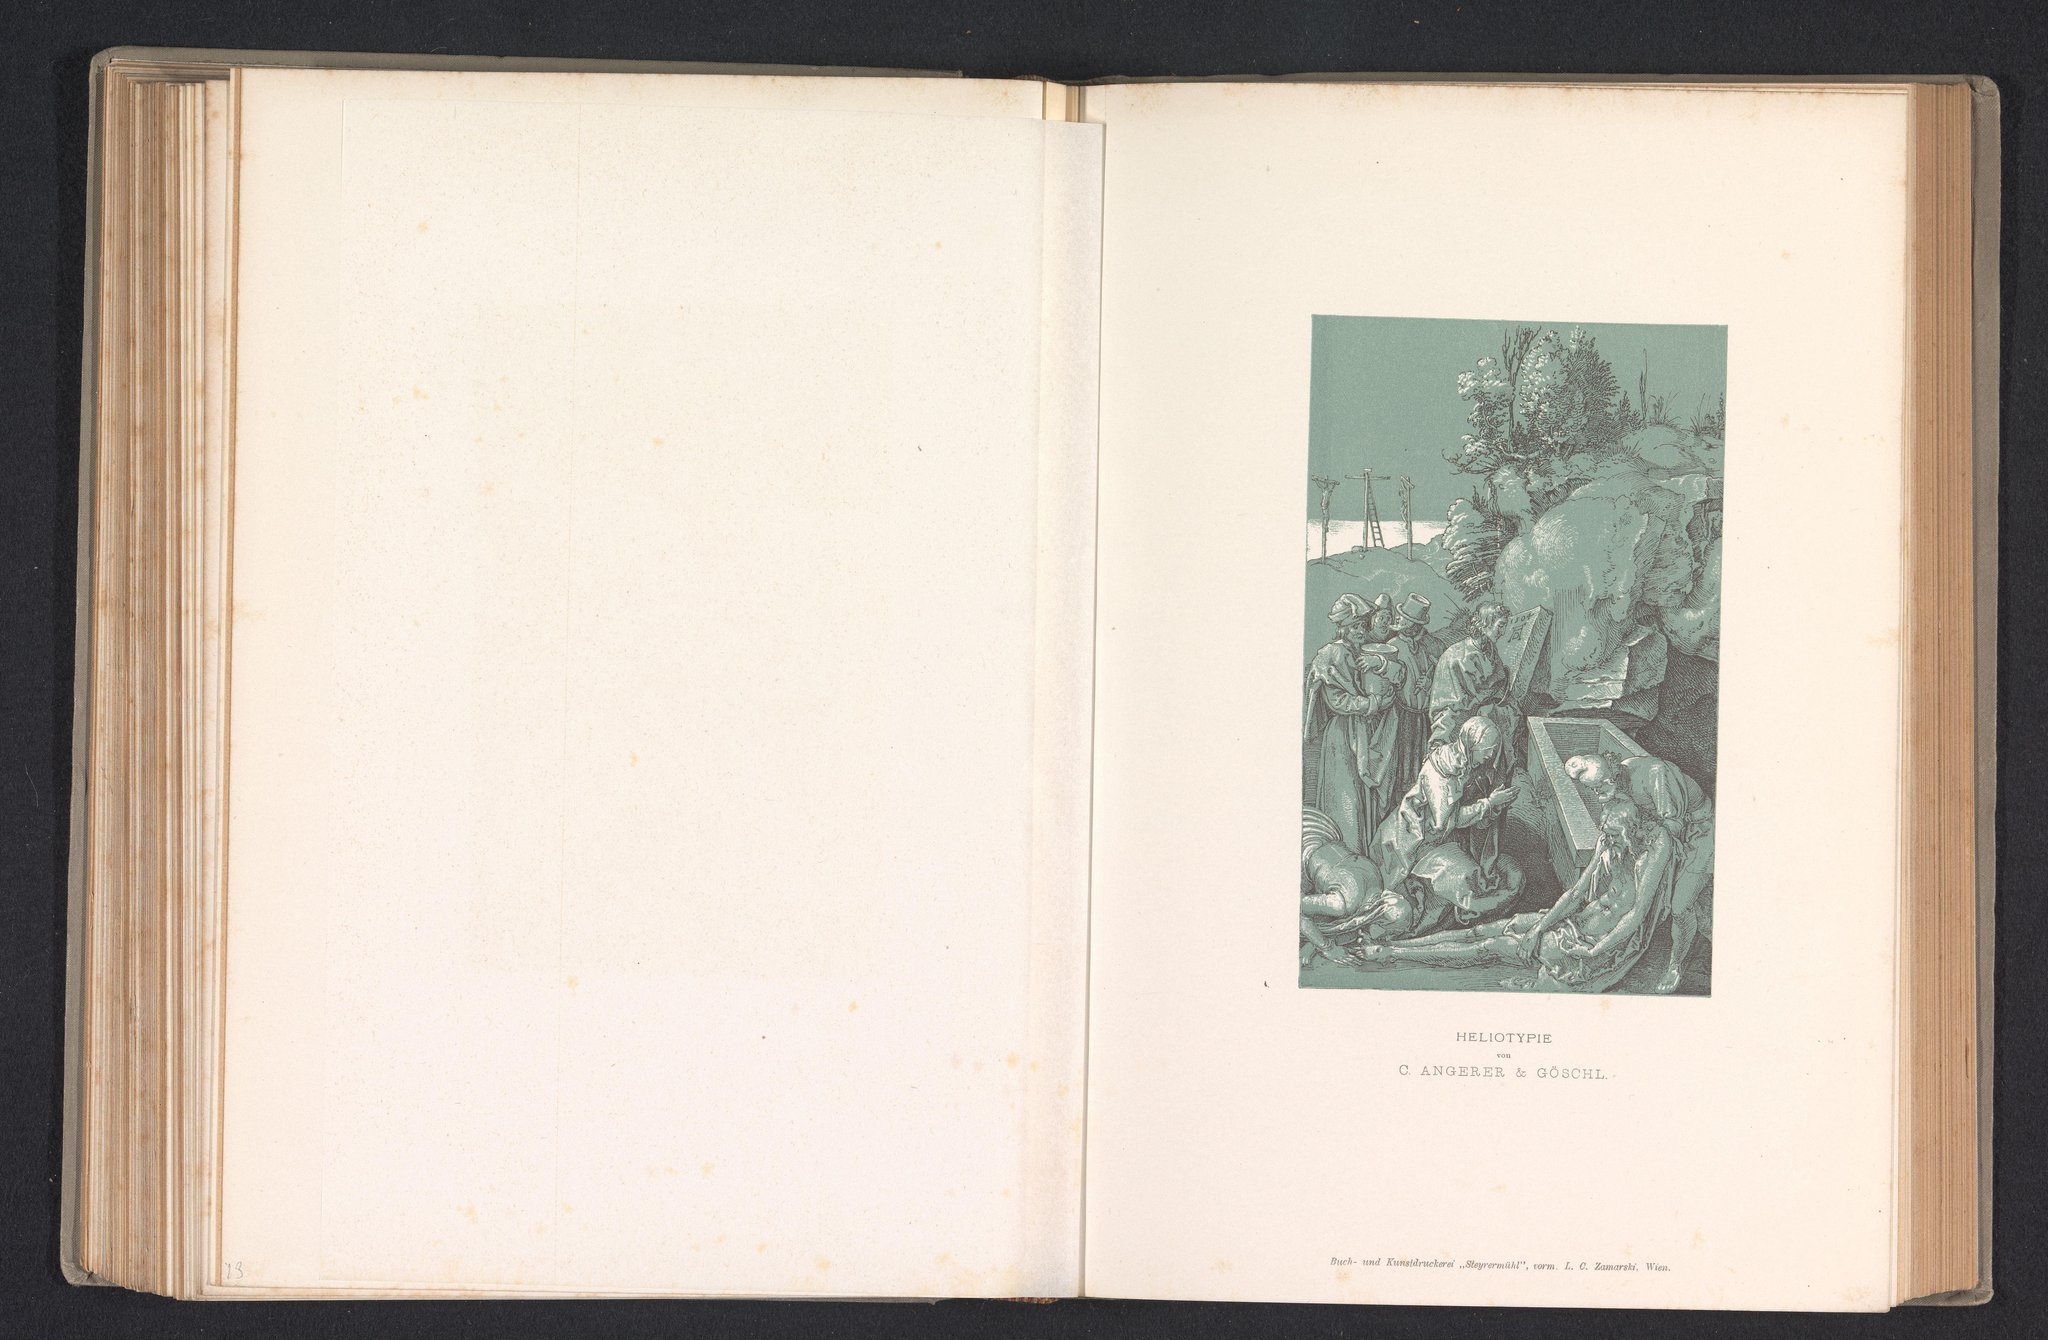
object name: page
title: Paysage d'après nature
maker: Anonymous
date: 1878-1883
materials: paper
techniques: photolithography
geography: paris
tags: forest path or lane